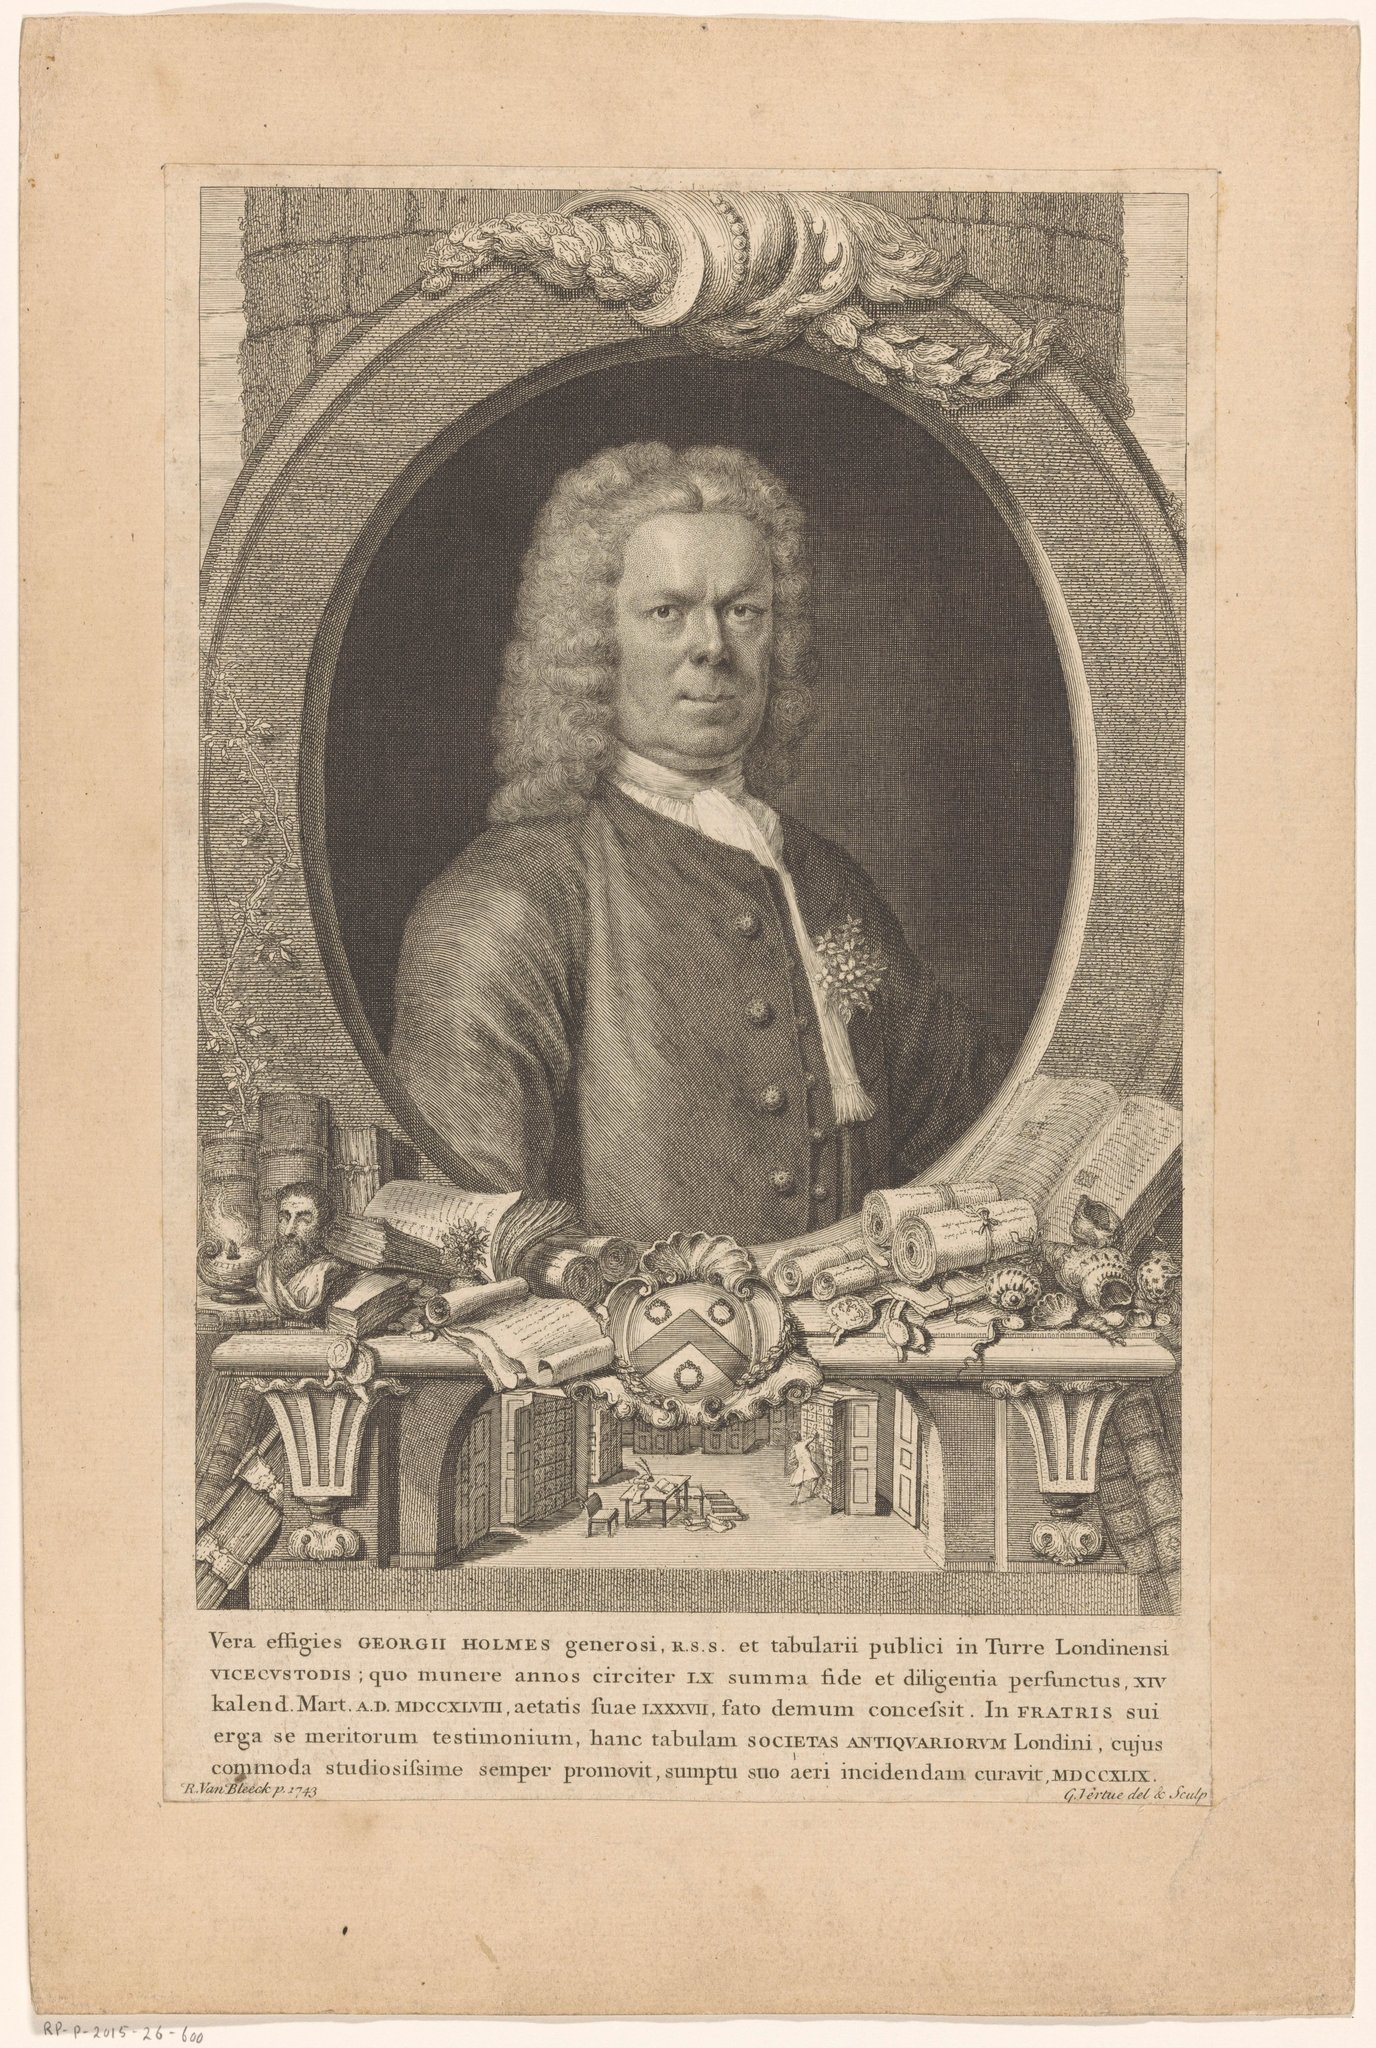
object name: book illustration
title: Portret van George Holmes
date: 1749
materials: paper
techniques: engraving, etching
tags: book, oil-lamp, piece of sculpture, reproduction of a piece of sculpture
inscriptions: collector's mark: Lugt 2228, collector's mark: Lugt 4779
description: Portret van de Britse archivaris George Holmes, ten halven lijve in een ovaal met onderin zijn wapen. Onder het portret een olielamp, een buste, boeken, archiefmateriaal en schelpen. Daaronder een kamer met in het midden een bureau.